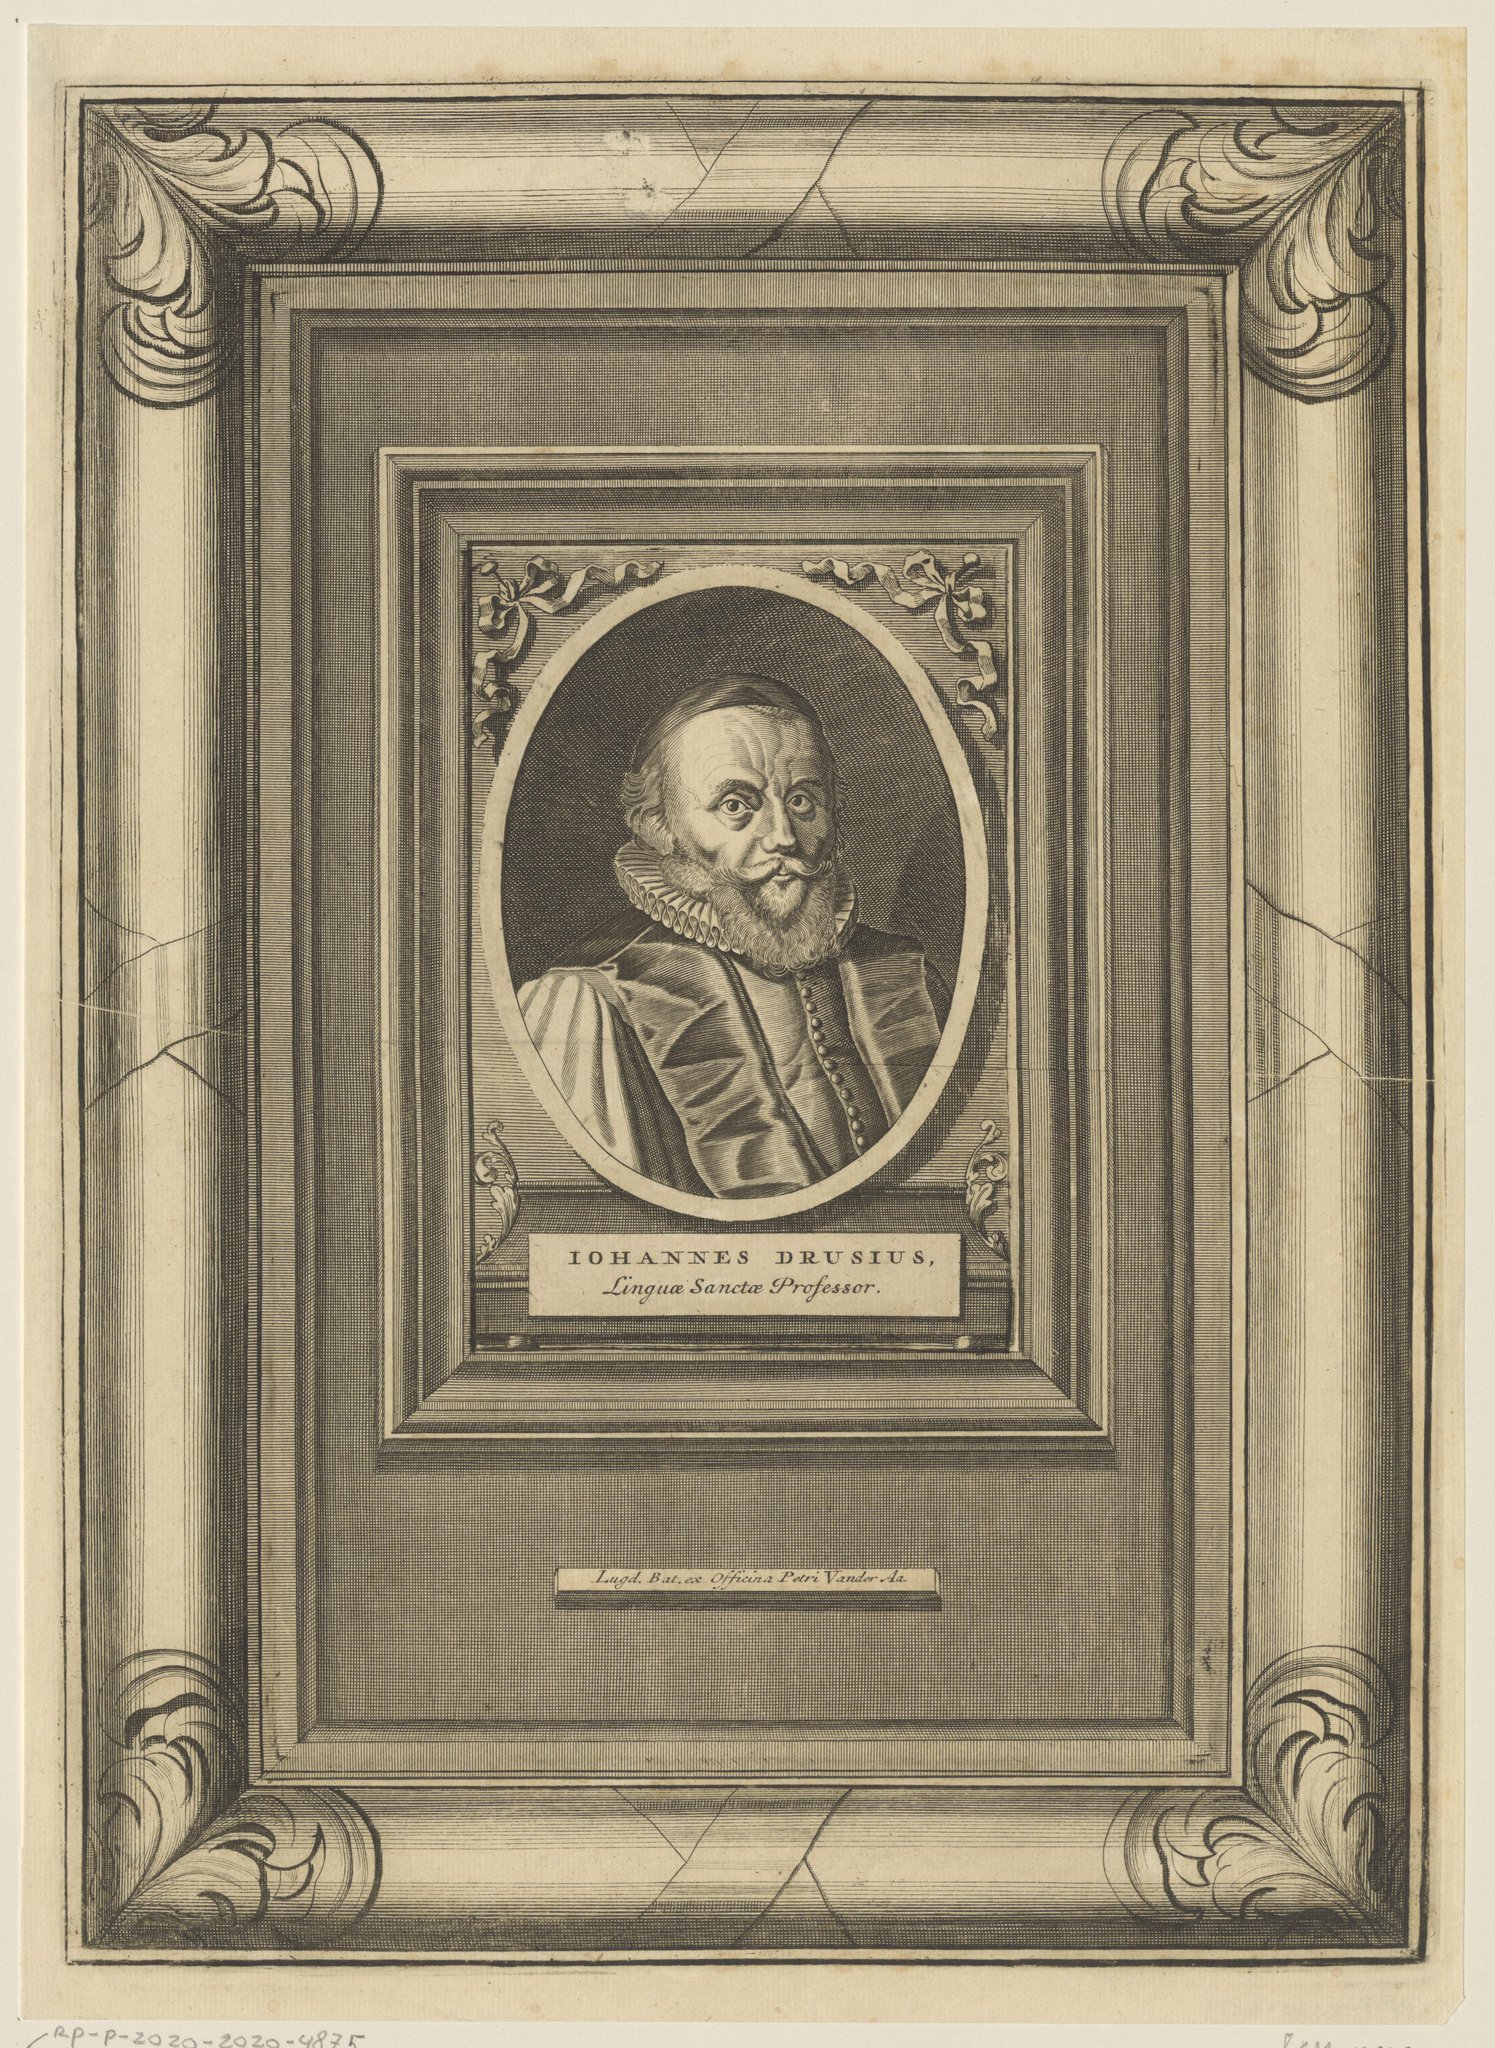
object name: print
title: Portret van Johannes van den Driesche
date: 1716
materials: paper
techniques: engraving, etching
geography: leiden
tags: theologian, historical persons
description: Prent zonder tweede omlijsting gebruikt in: Fundatoris curatorum et professorum celeberrimorum, (...) academia Lugduno-Batava (...). Leiden: Pieter van der Aa, [ca. 1716].